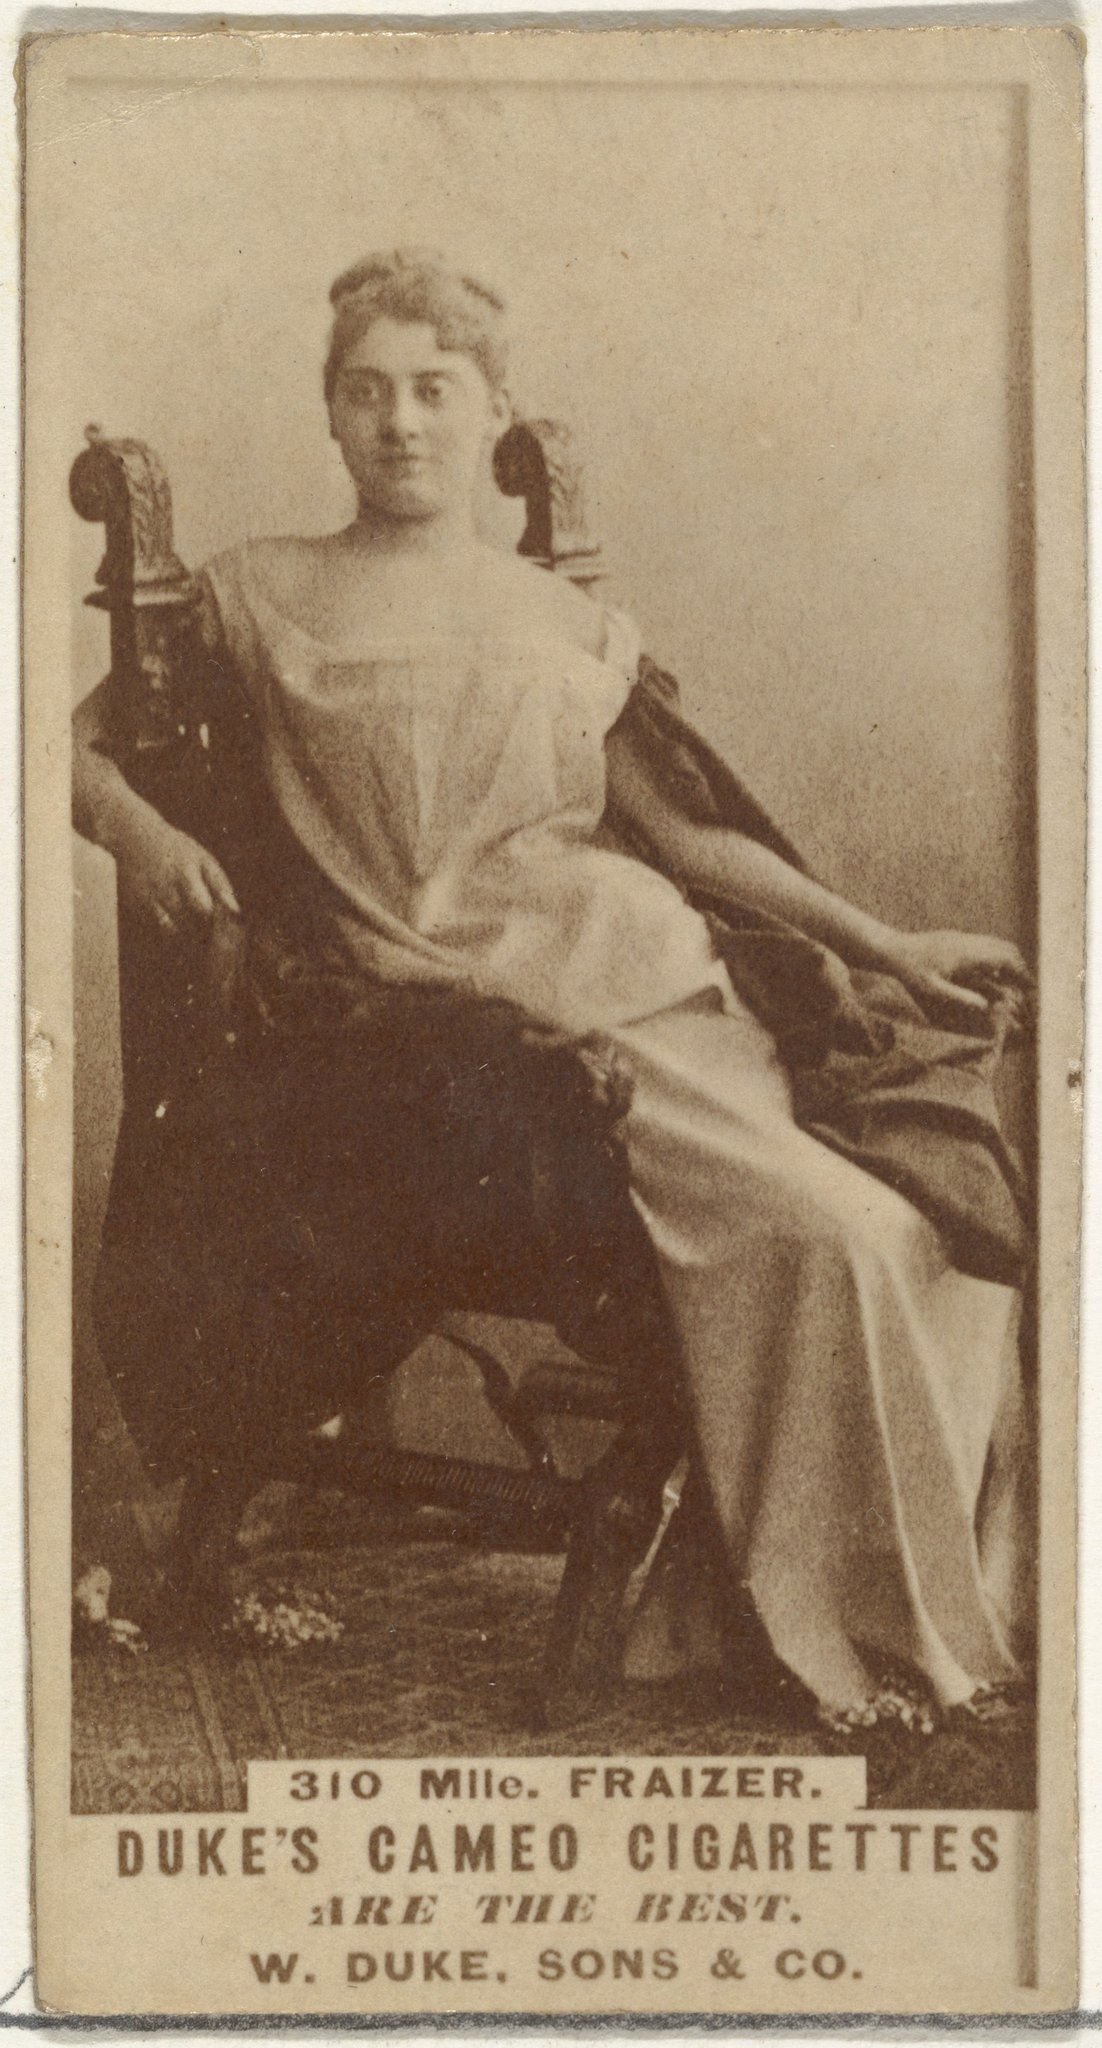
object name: photograph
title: Card Number 310, Mlle. Fraizer, from the Actors and Actresses series (N145-5) issued by Duke Sons & Co. to promote Cameo Cigarettes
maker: w. duke, sons & co.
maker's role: publisher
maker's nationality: american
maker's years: 1870-1920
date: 1880-1889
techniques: albumen silver print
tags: portraits,women,actresses